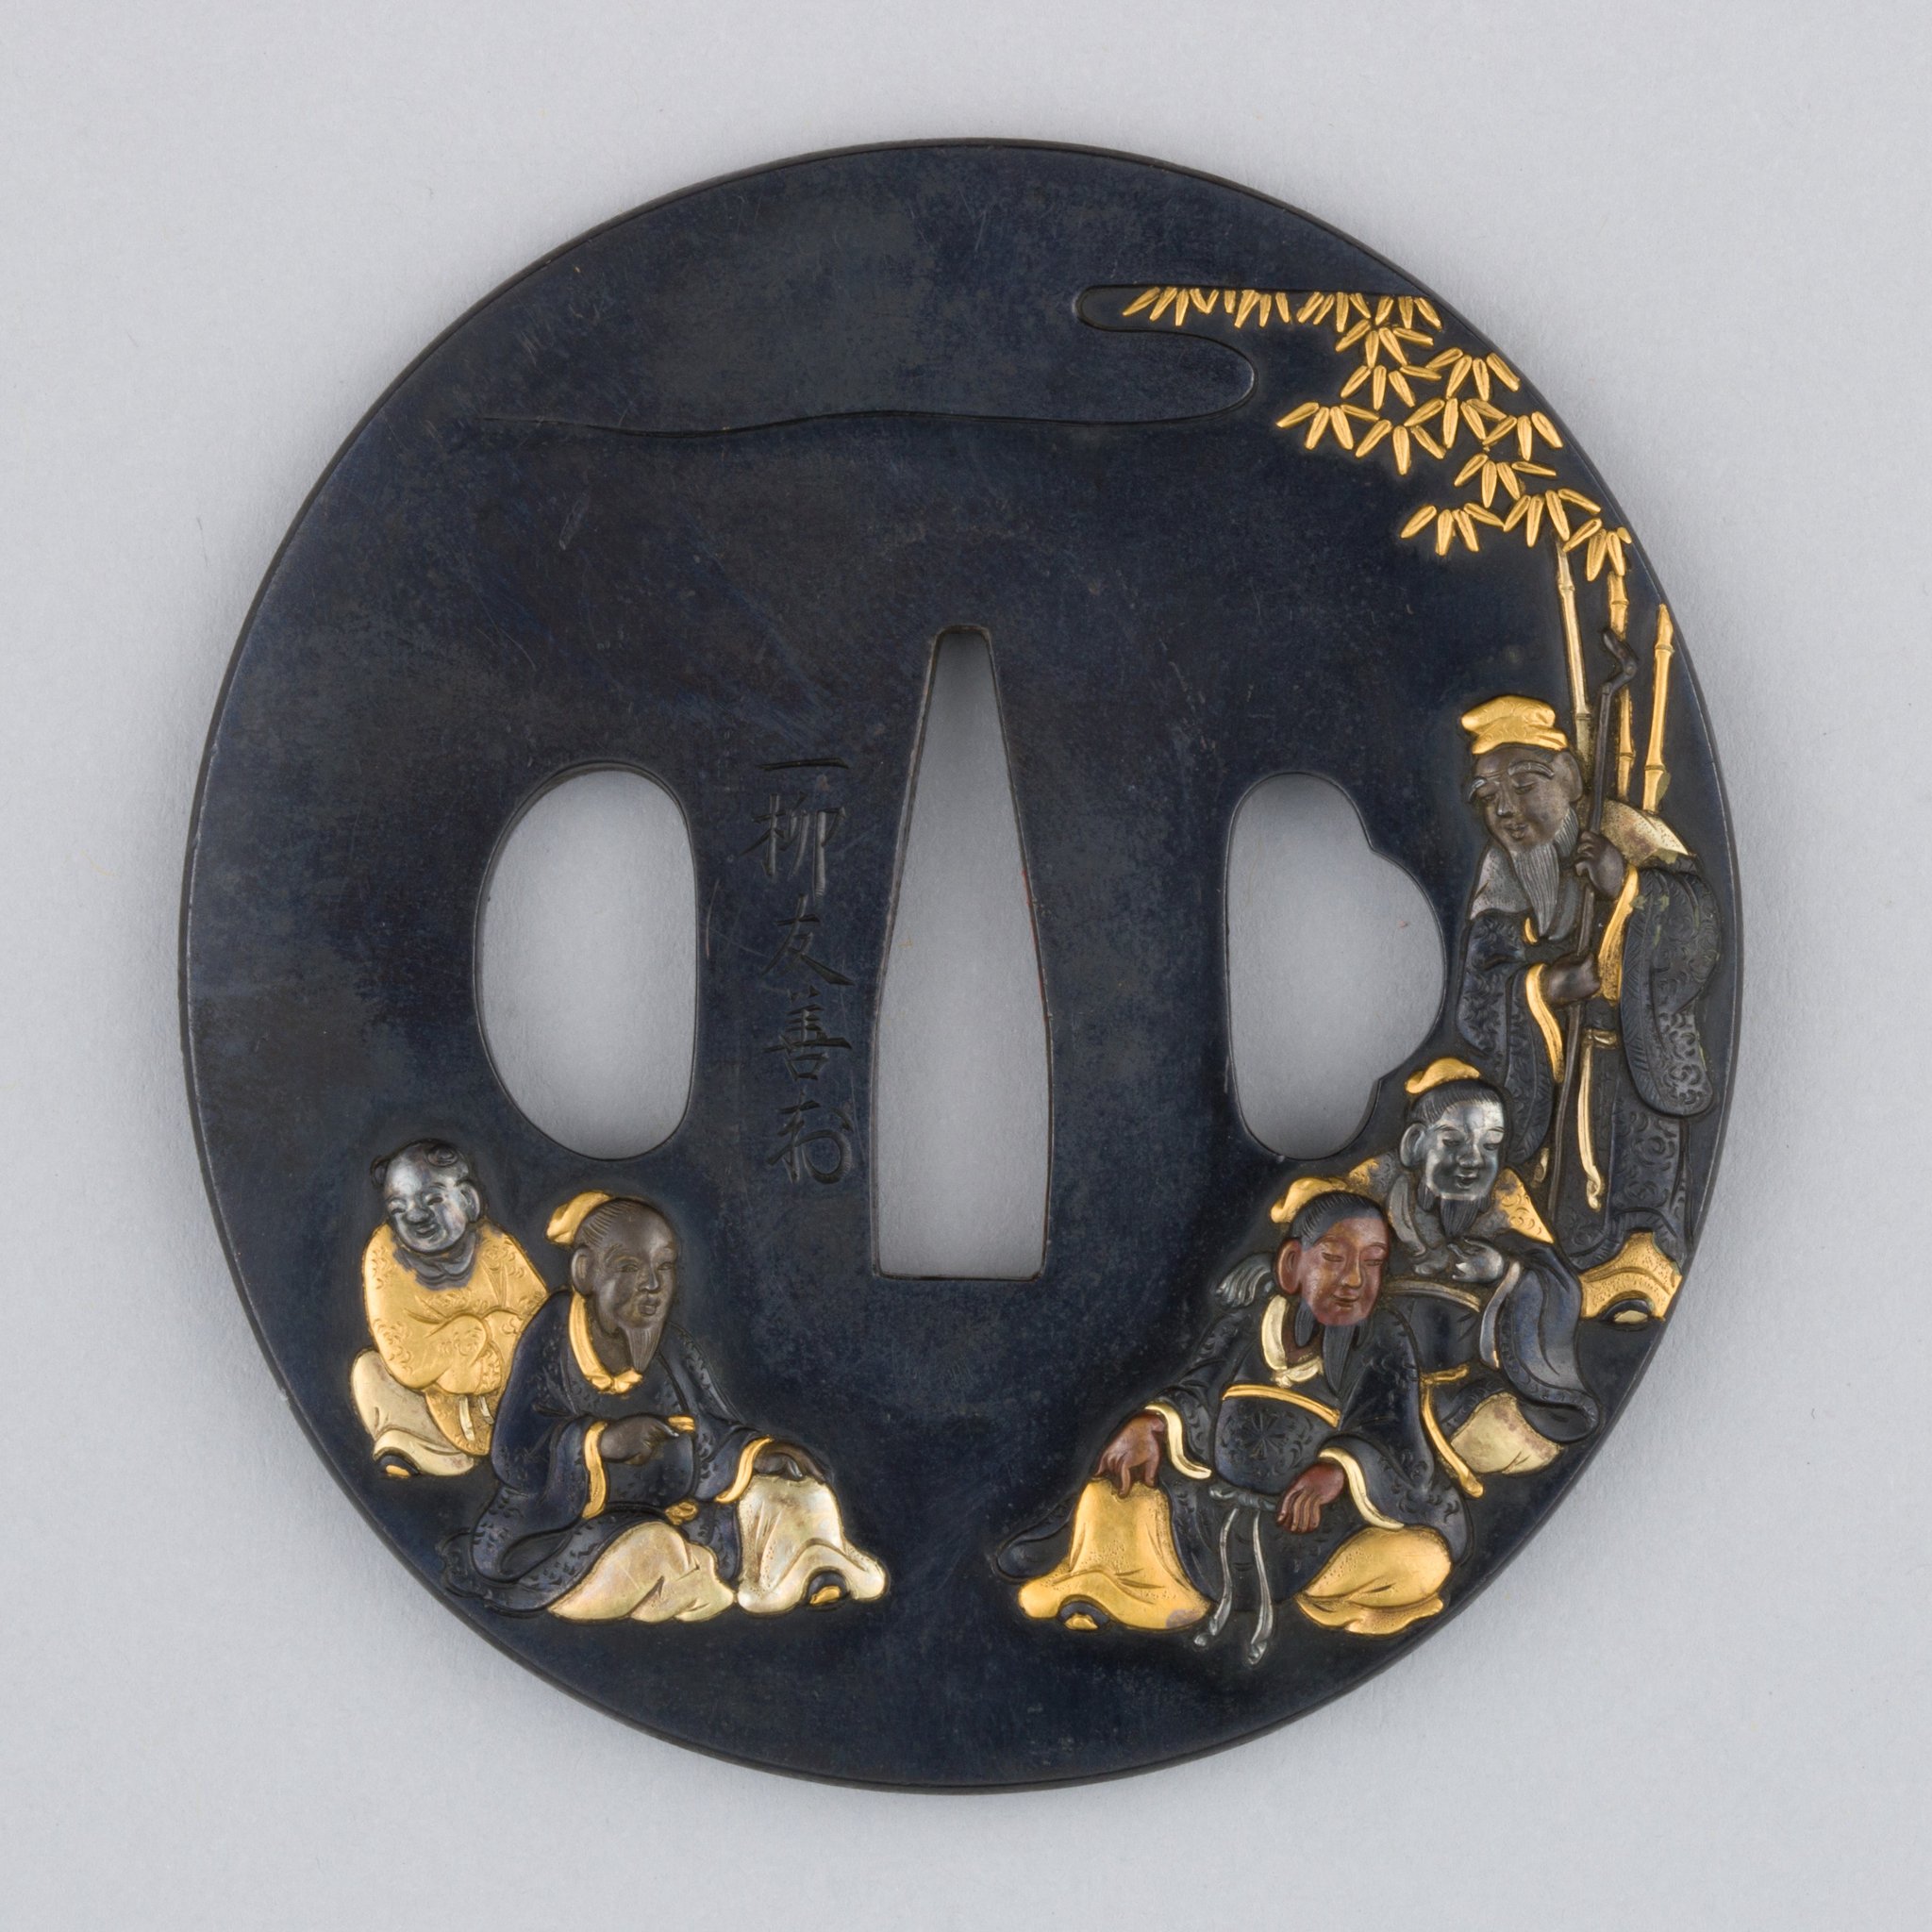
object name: sword guard tsuba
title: Sword Guard (Tsuba)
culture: japanese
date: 1615-1868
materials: copper, gold alloy, silver alloy, gold, silver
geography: japan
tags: men